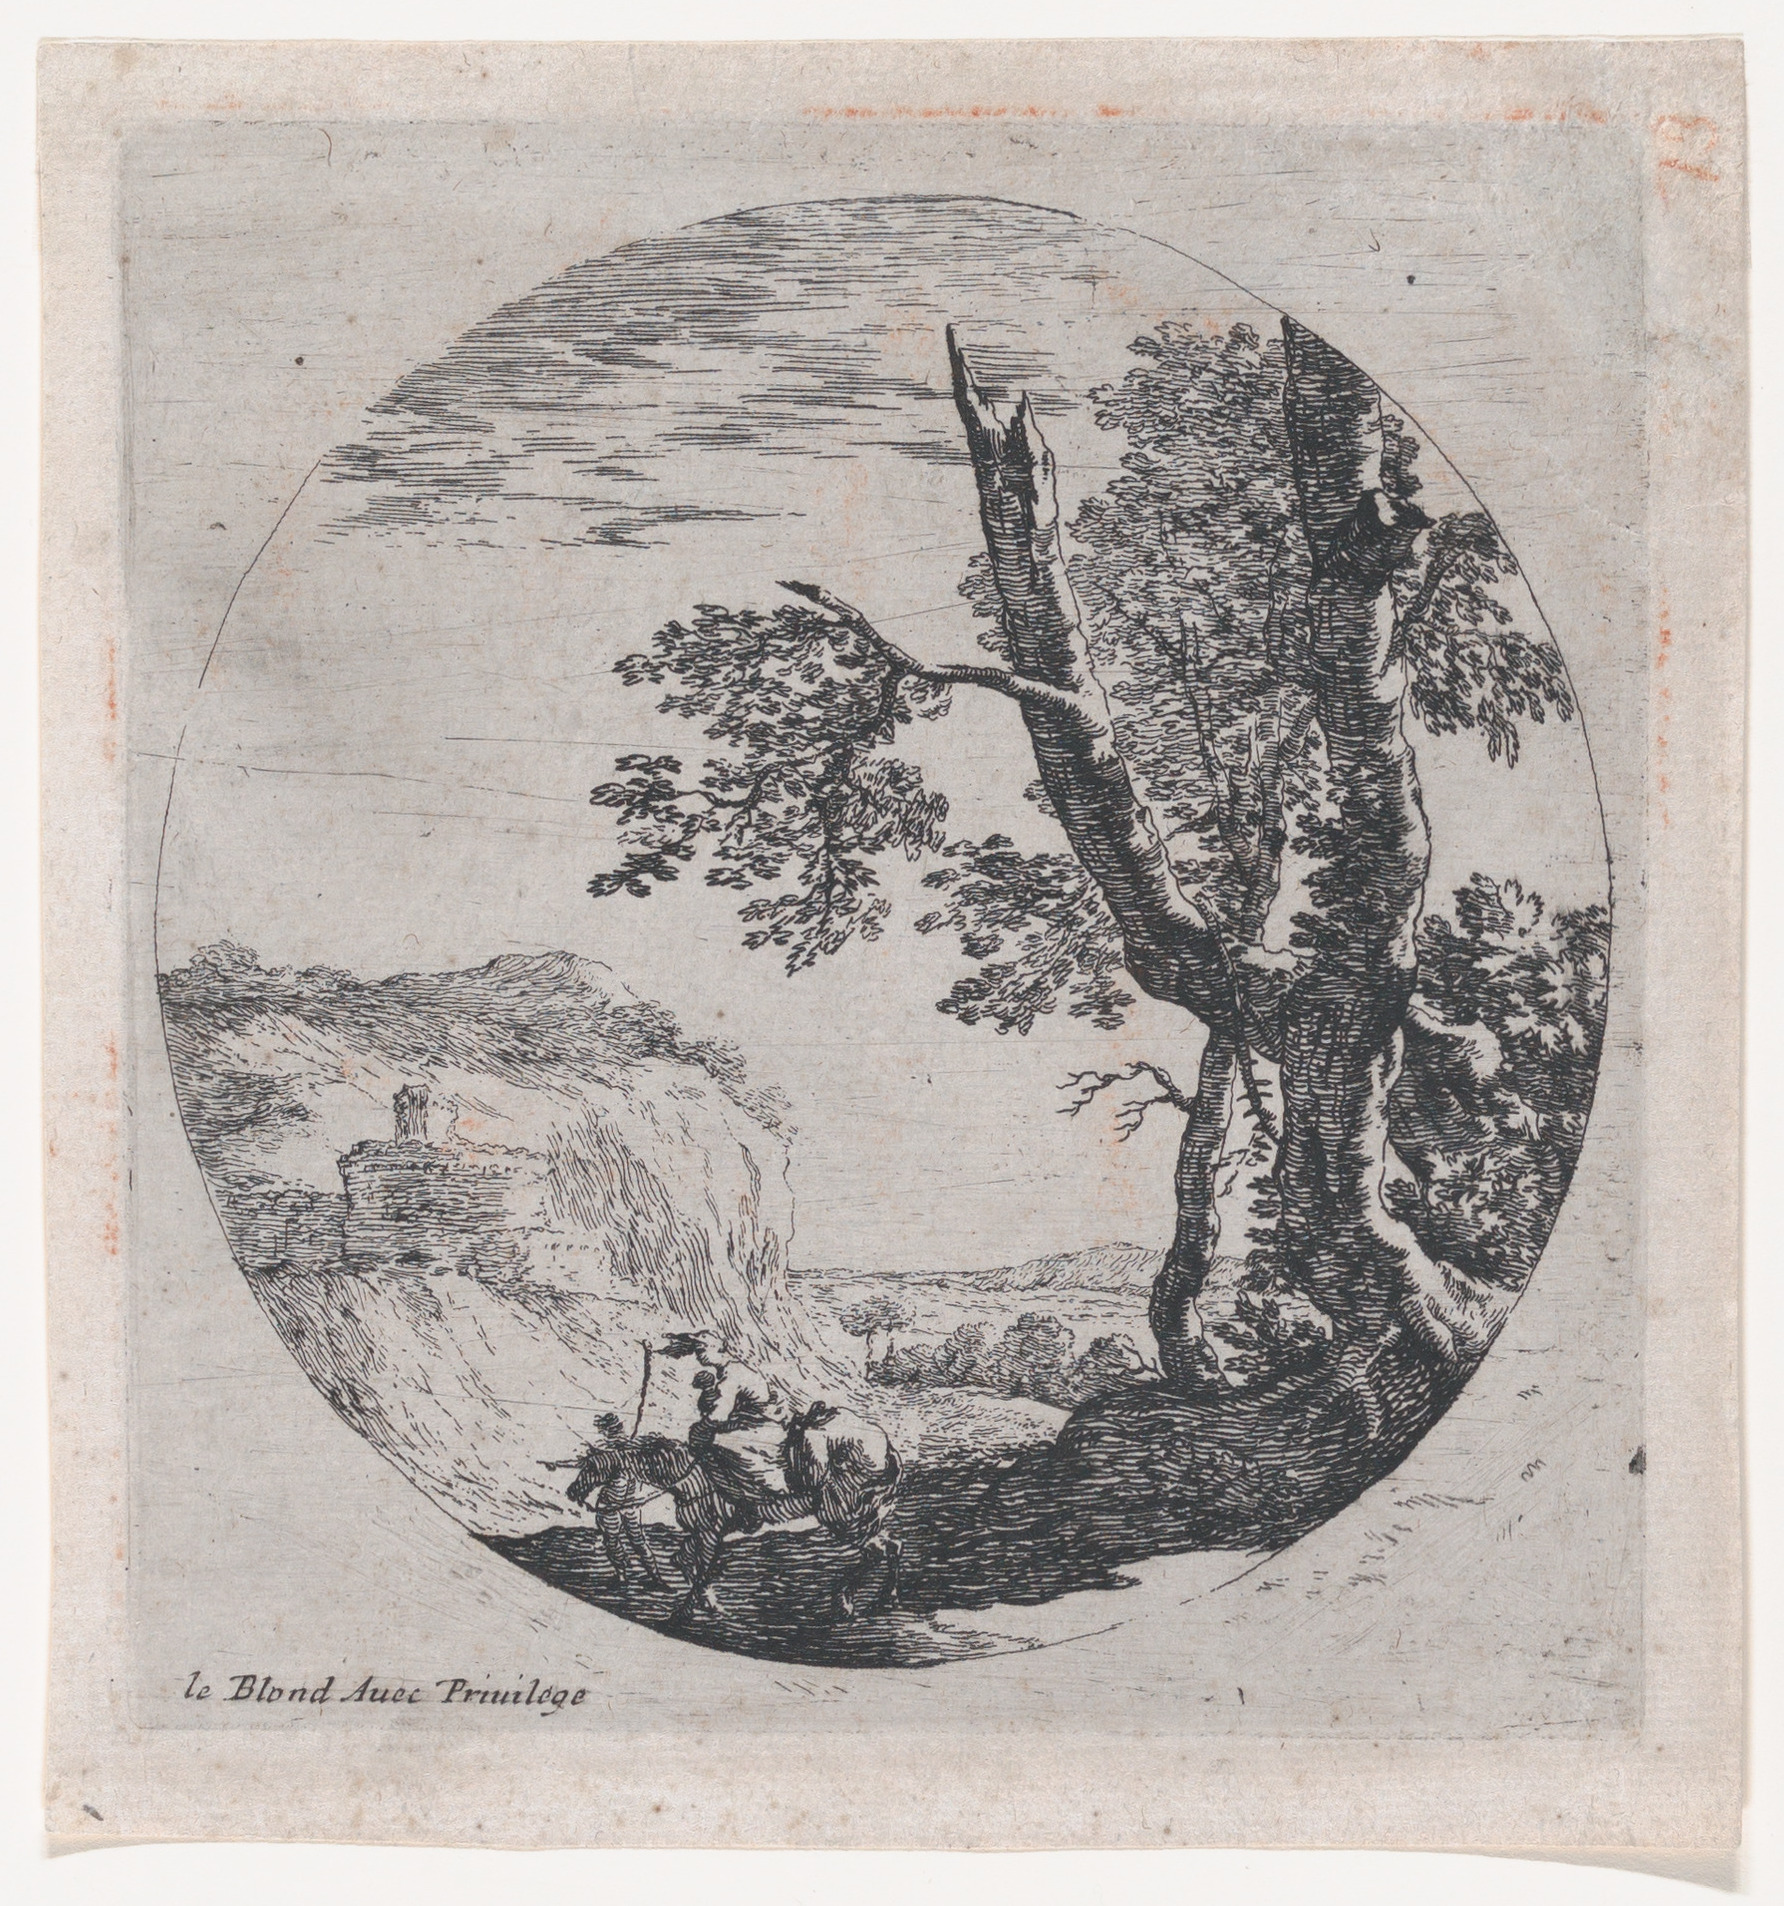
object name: print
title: Landscape with the Flight into Egypt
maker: anonymous, french, 17th century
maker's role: artist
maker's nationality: french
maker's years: 1600-1700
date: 1601-1700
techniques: etching